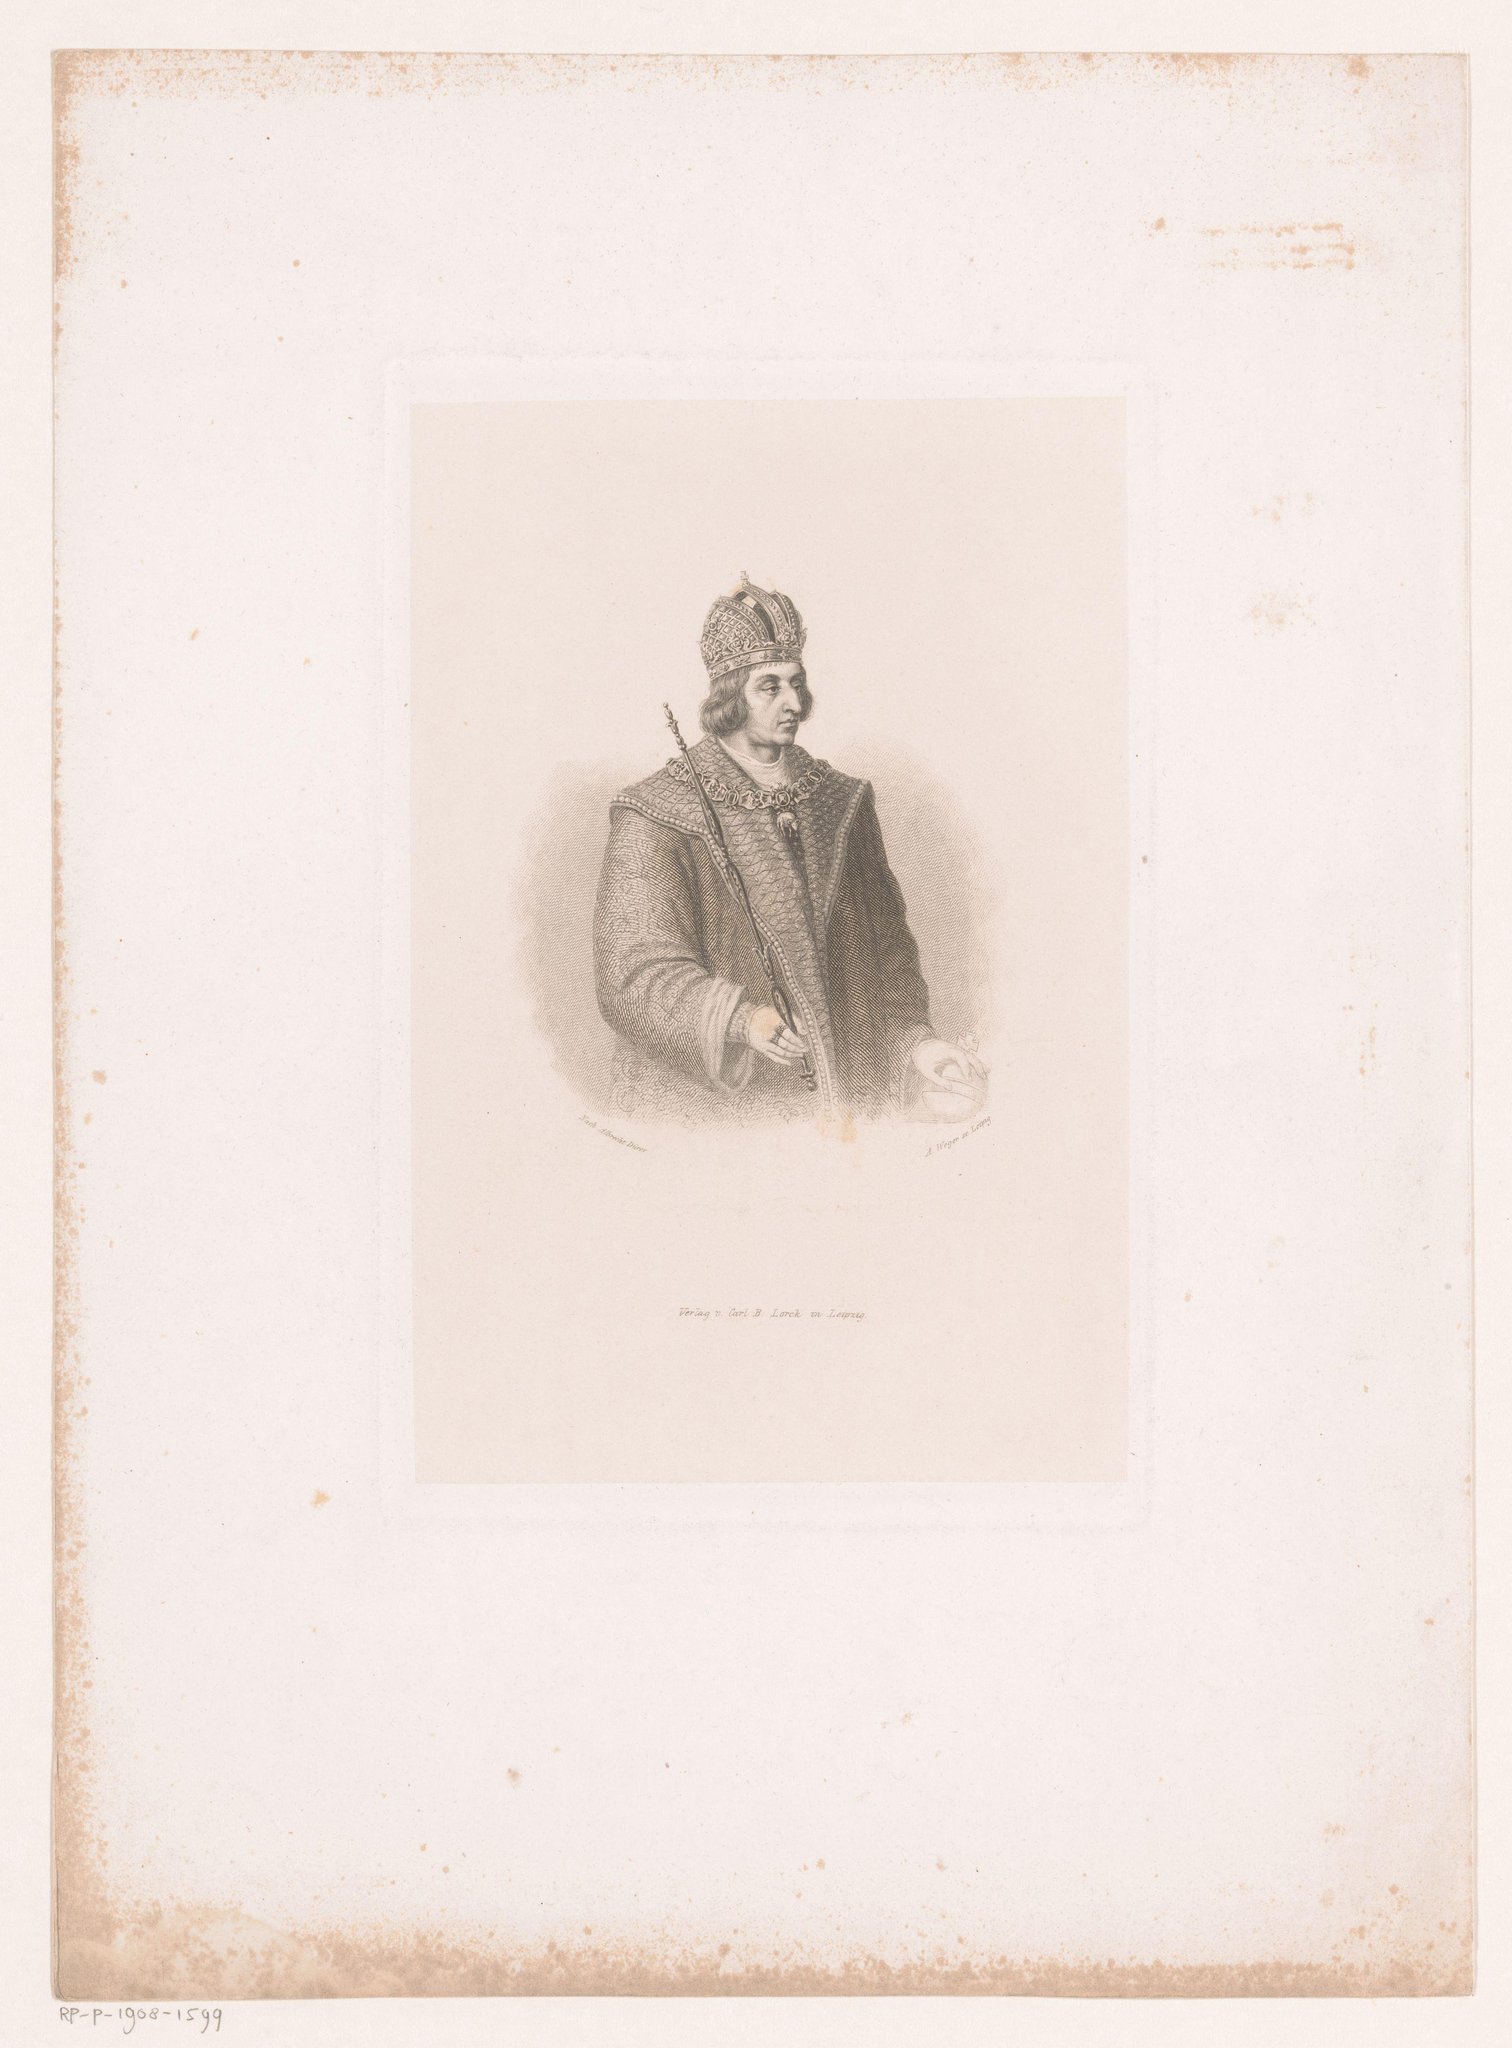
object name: print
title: Portret van keizer Maximiliaan I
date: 1849-1892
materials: paper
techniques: engraving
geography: leipzig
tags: maximilian i (holy roman emperor), historical persons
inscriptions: collector's mark: Lugt 2228